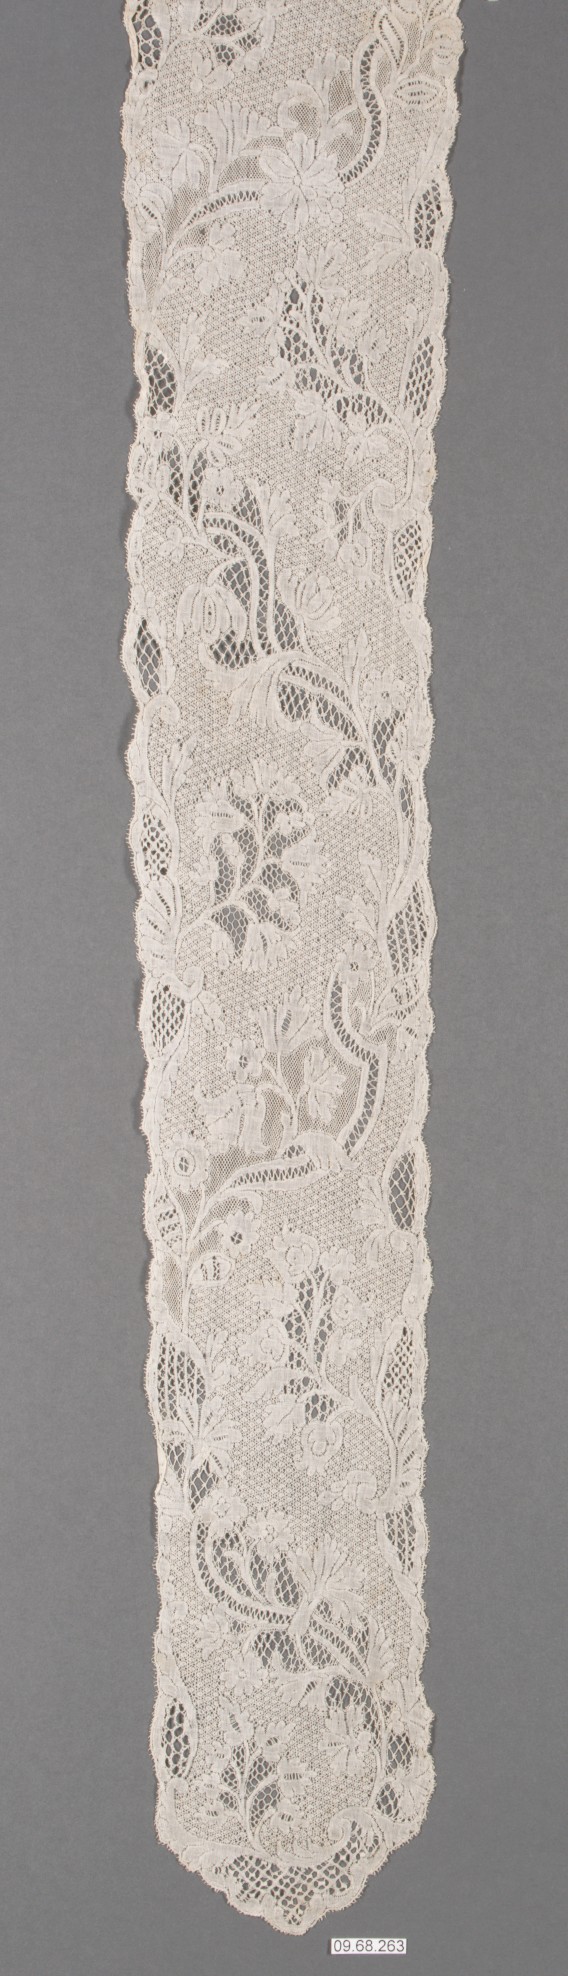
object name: lappet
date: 1701-1800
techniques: lace